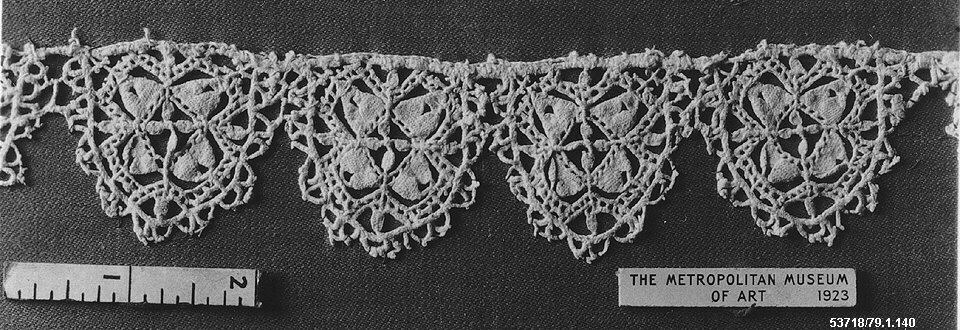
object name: edging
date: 1501-1700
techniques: lace